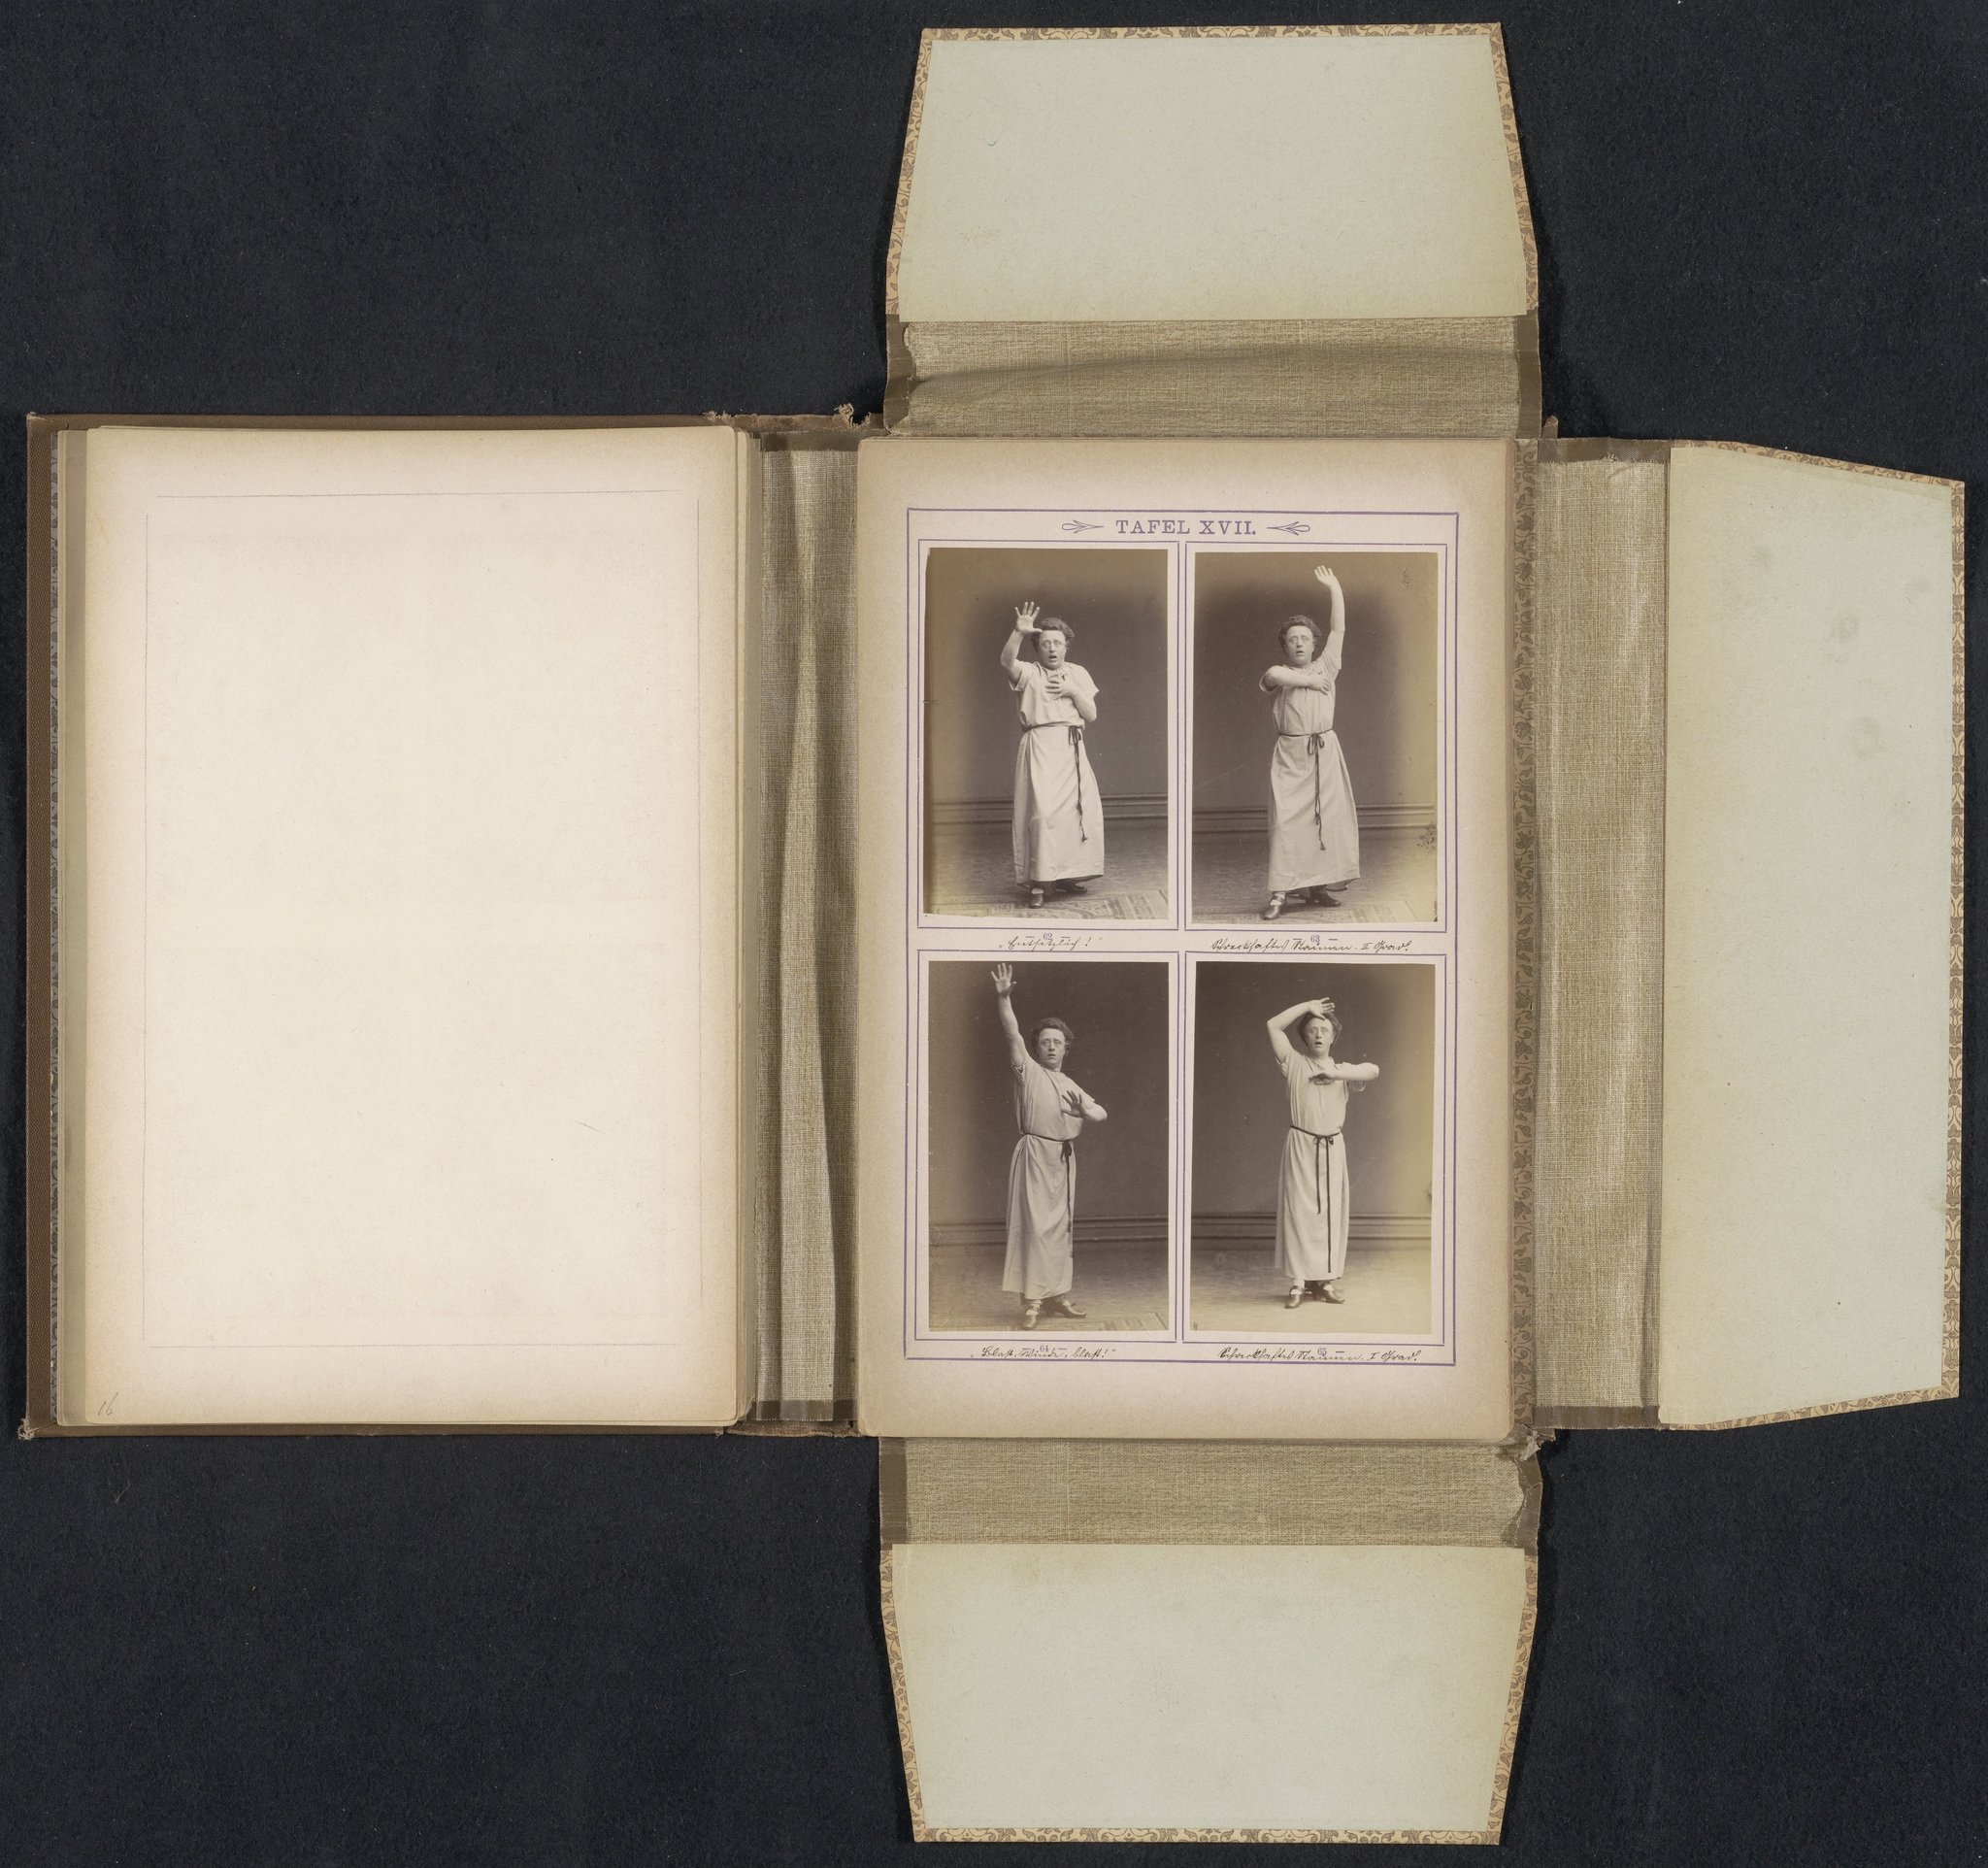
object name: photograph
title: Portretten van een man in vier poses met gestrekte armen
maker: nicola tonger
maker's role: fotograaf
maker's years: 1846-1917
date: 1881-1886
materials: cardboard, photographic support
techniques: albumen print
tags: gesture-language, arm raised upward, arm stretched sidewards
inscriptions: number: ‘Tafel XVII.’, inscription: ‘,,Entsetzlich!'' (...) Staunen’, number: ‘62 (...) 65’